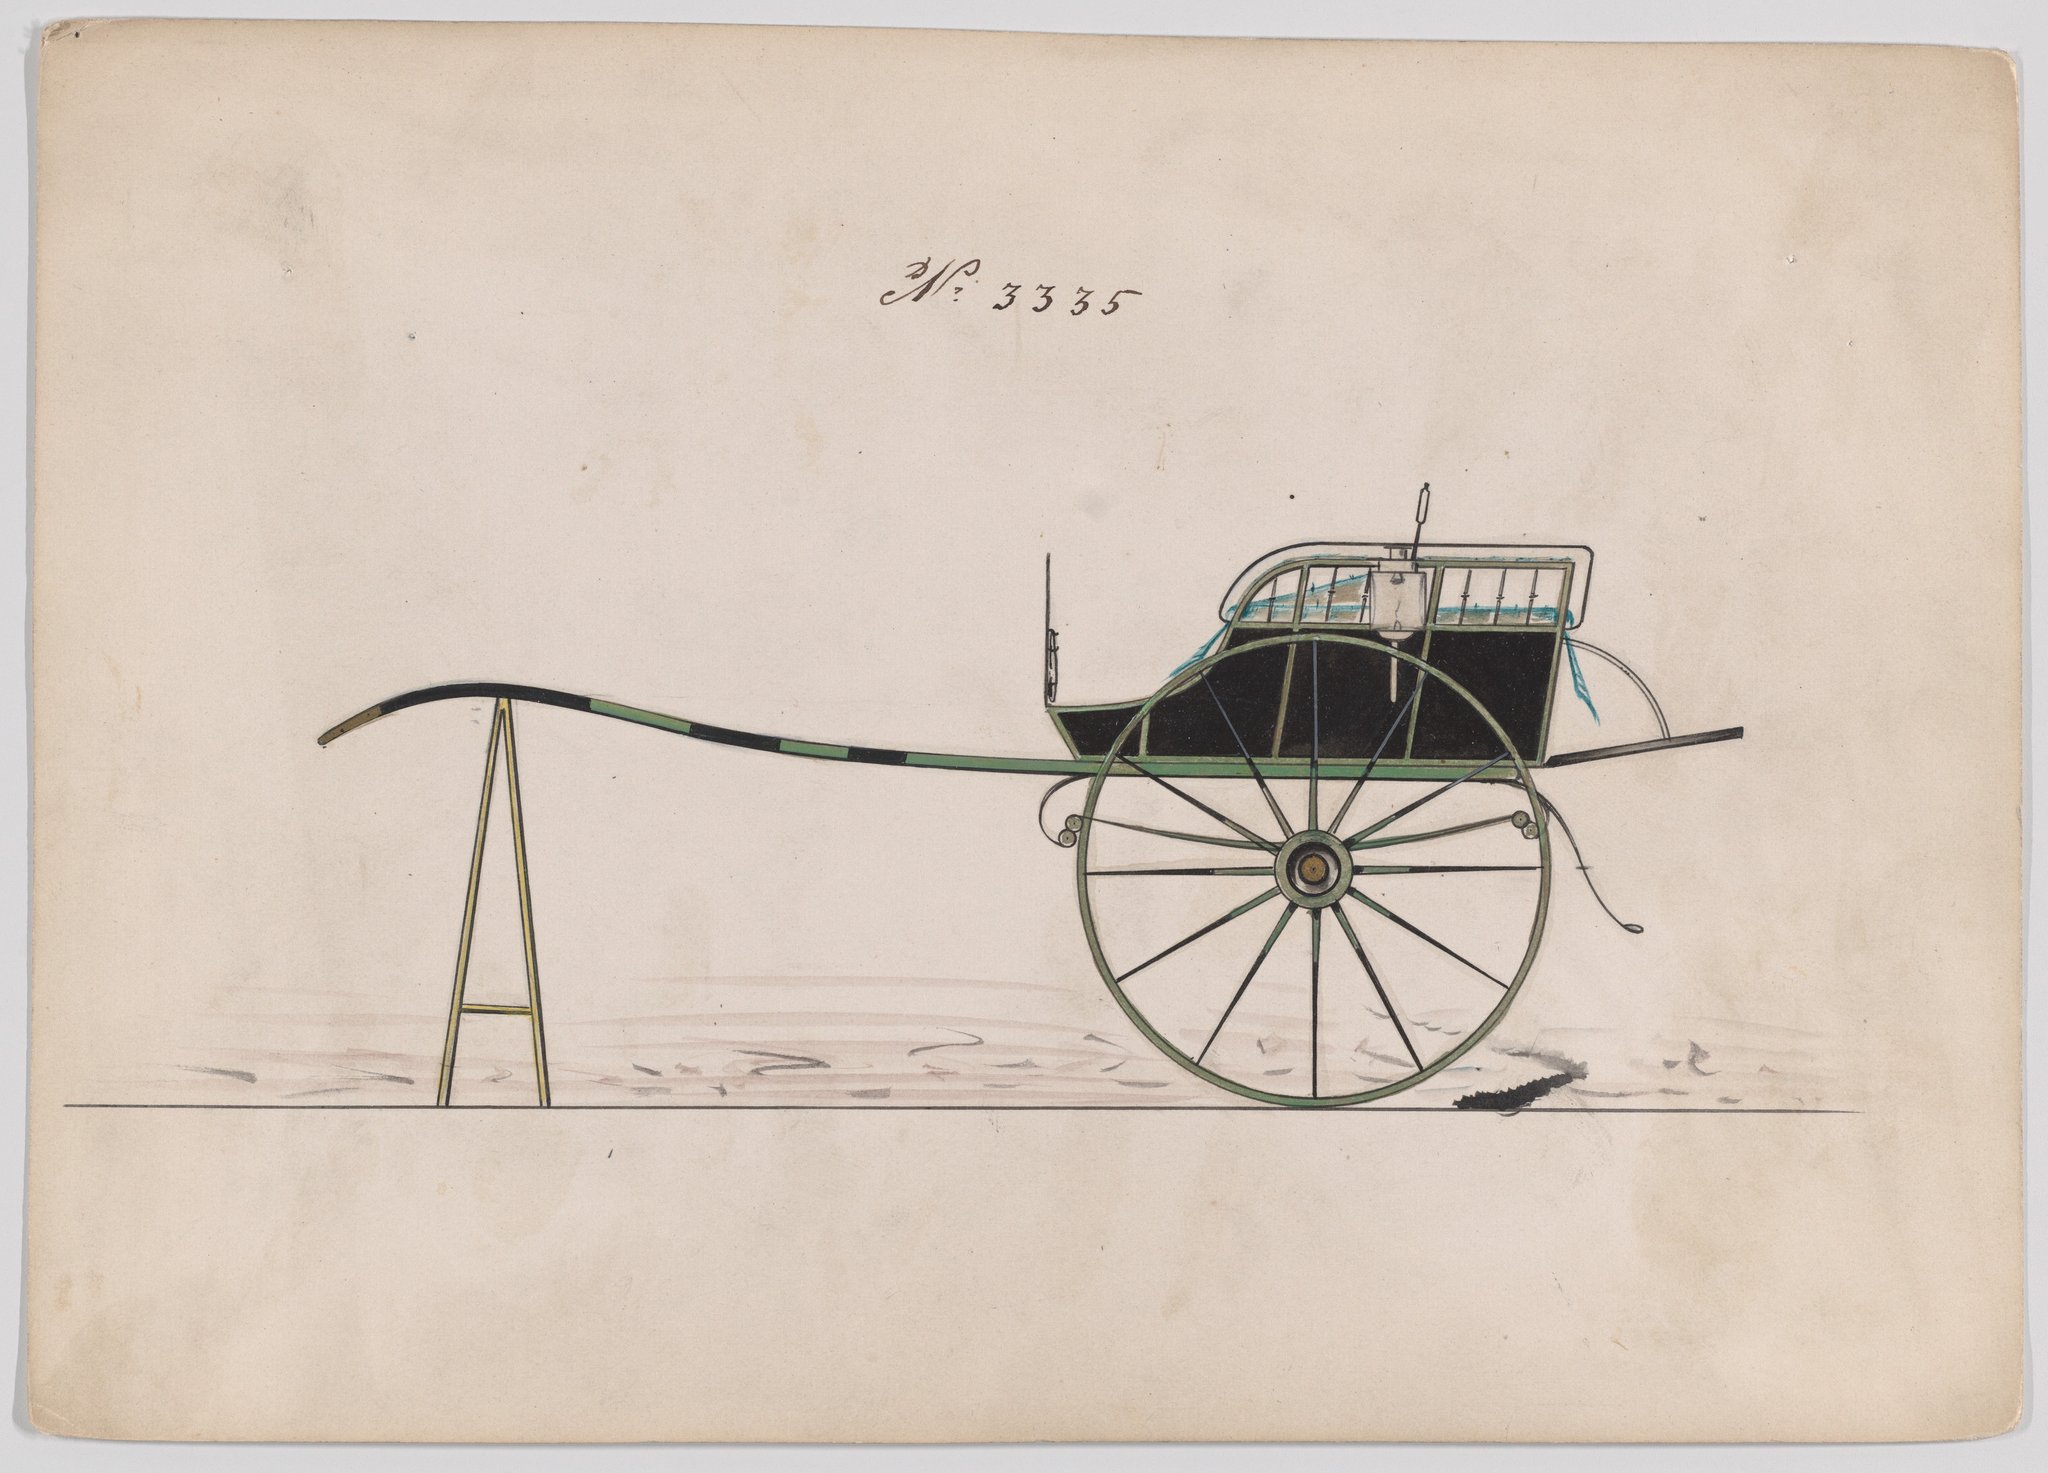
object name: drawing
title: Whitechapel Cart # 3335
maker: brewster & co.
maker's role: manufacturer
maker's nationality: american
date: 1877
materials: gouache, gum arabic, ink, watercolor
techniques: pen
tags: carriages